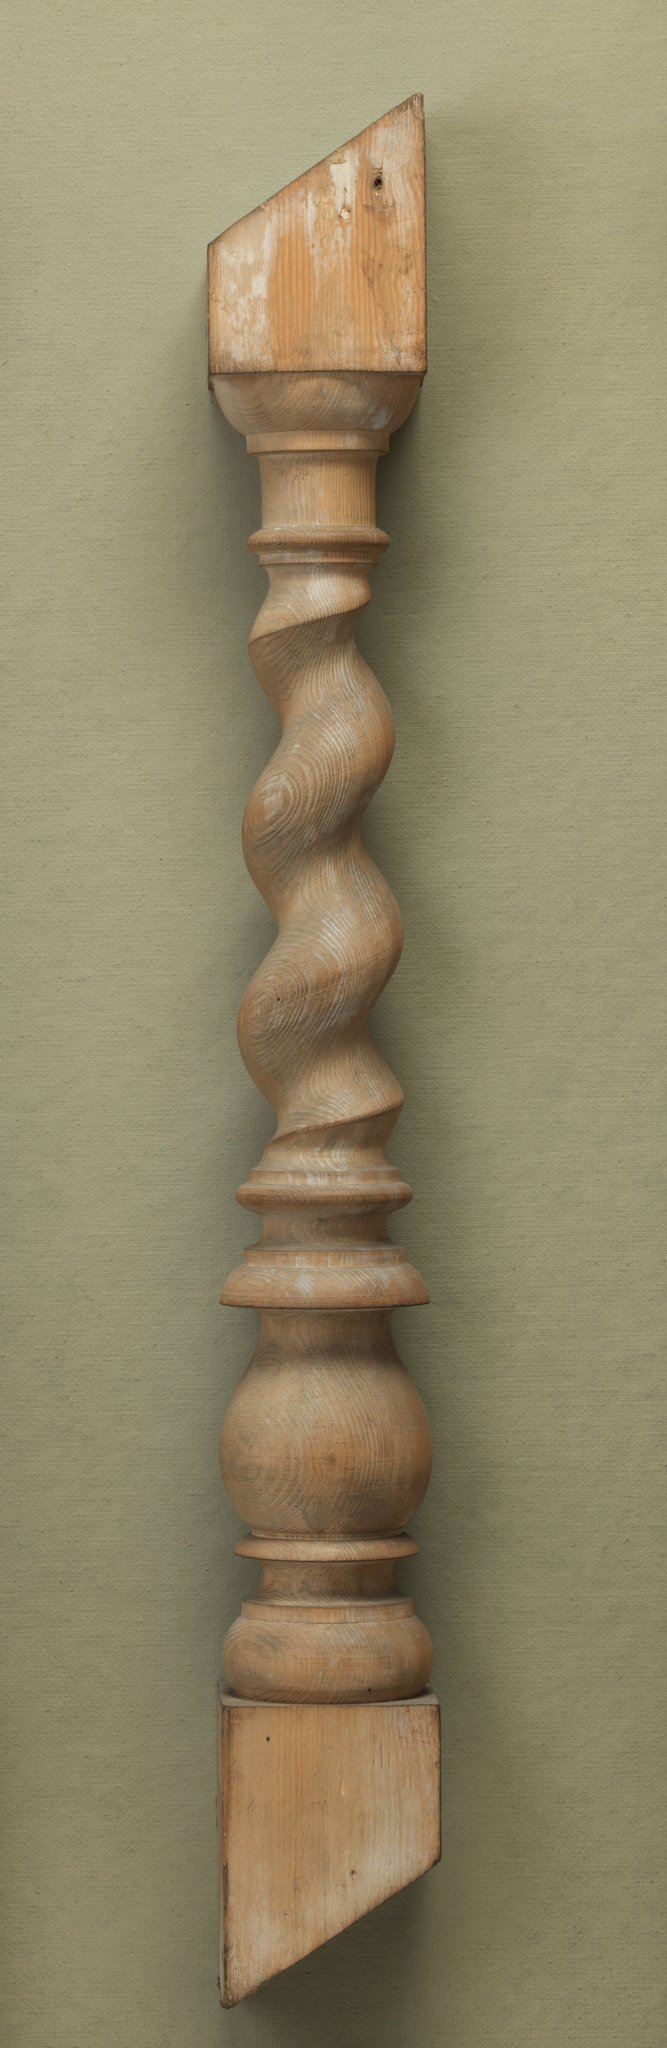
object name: baluster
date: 1667-1733